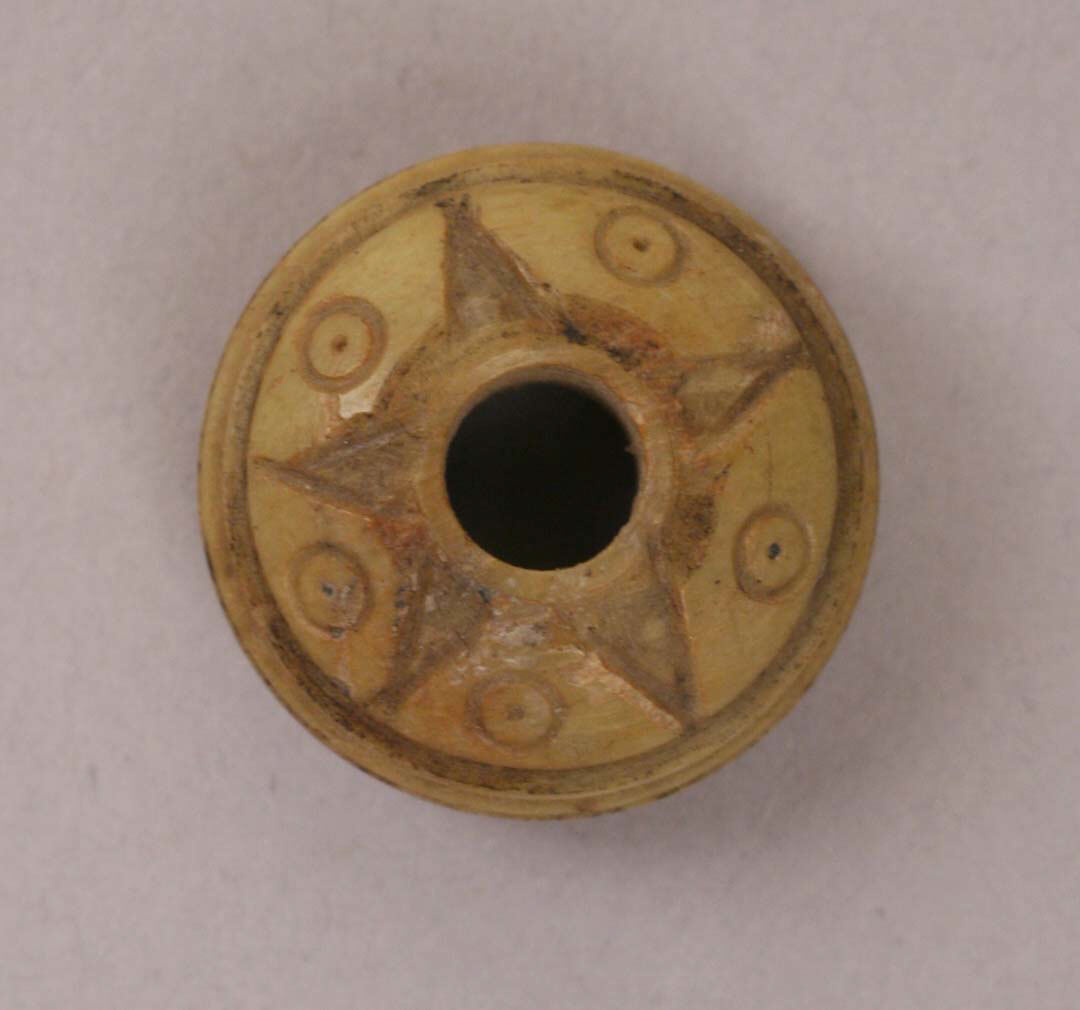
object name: button or bead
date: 801-1000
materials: bone, paint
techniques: incising, inlay, tinting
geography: iran